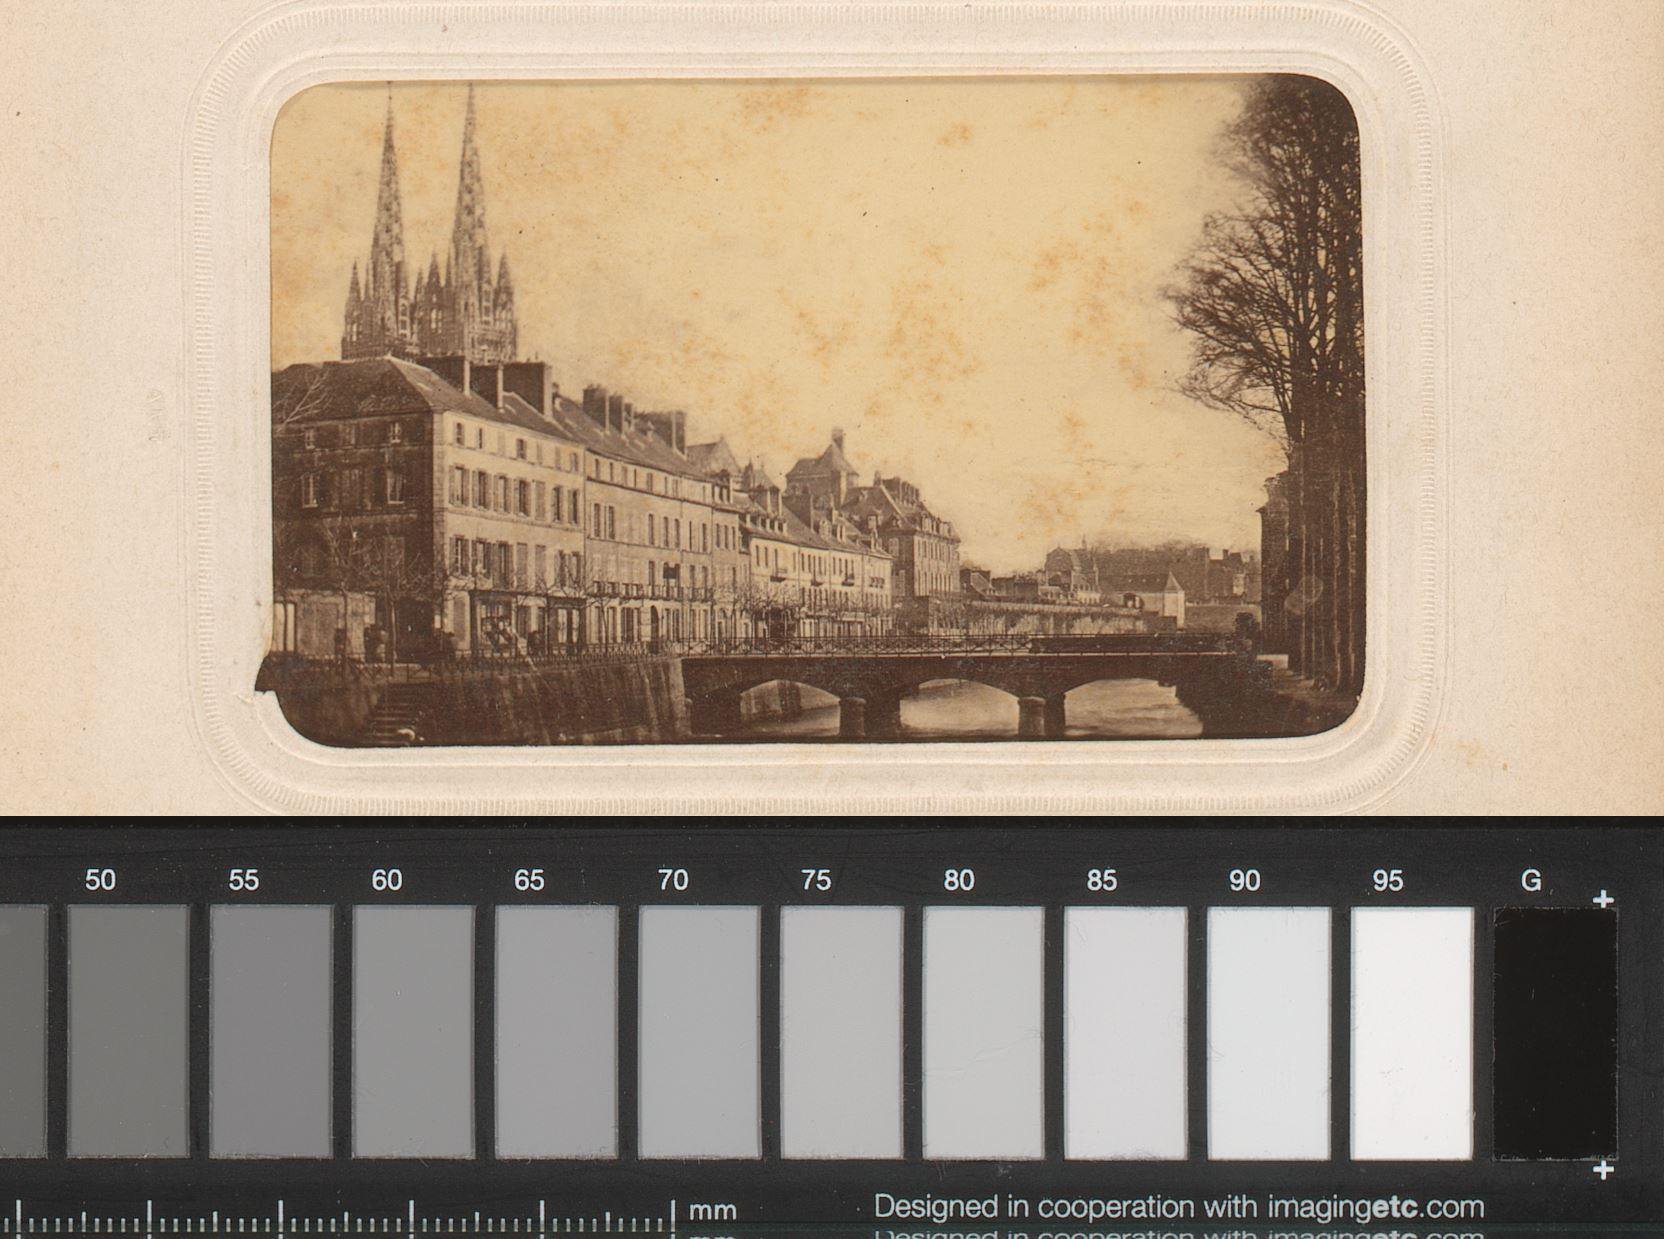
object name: album leaf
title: Stadsgezicht met op de achtergrond de kathedraal van Quimper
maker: villard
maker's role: fotograaf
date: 1860-1900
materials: cardboard, photographic support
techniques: albumen print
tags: city-view in general; 'veduta', canal, church (exterior)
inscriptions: inscription: ‘Villaard, phot/ [...]’, annotation: ‘quimper’